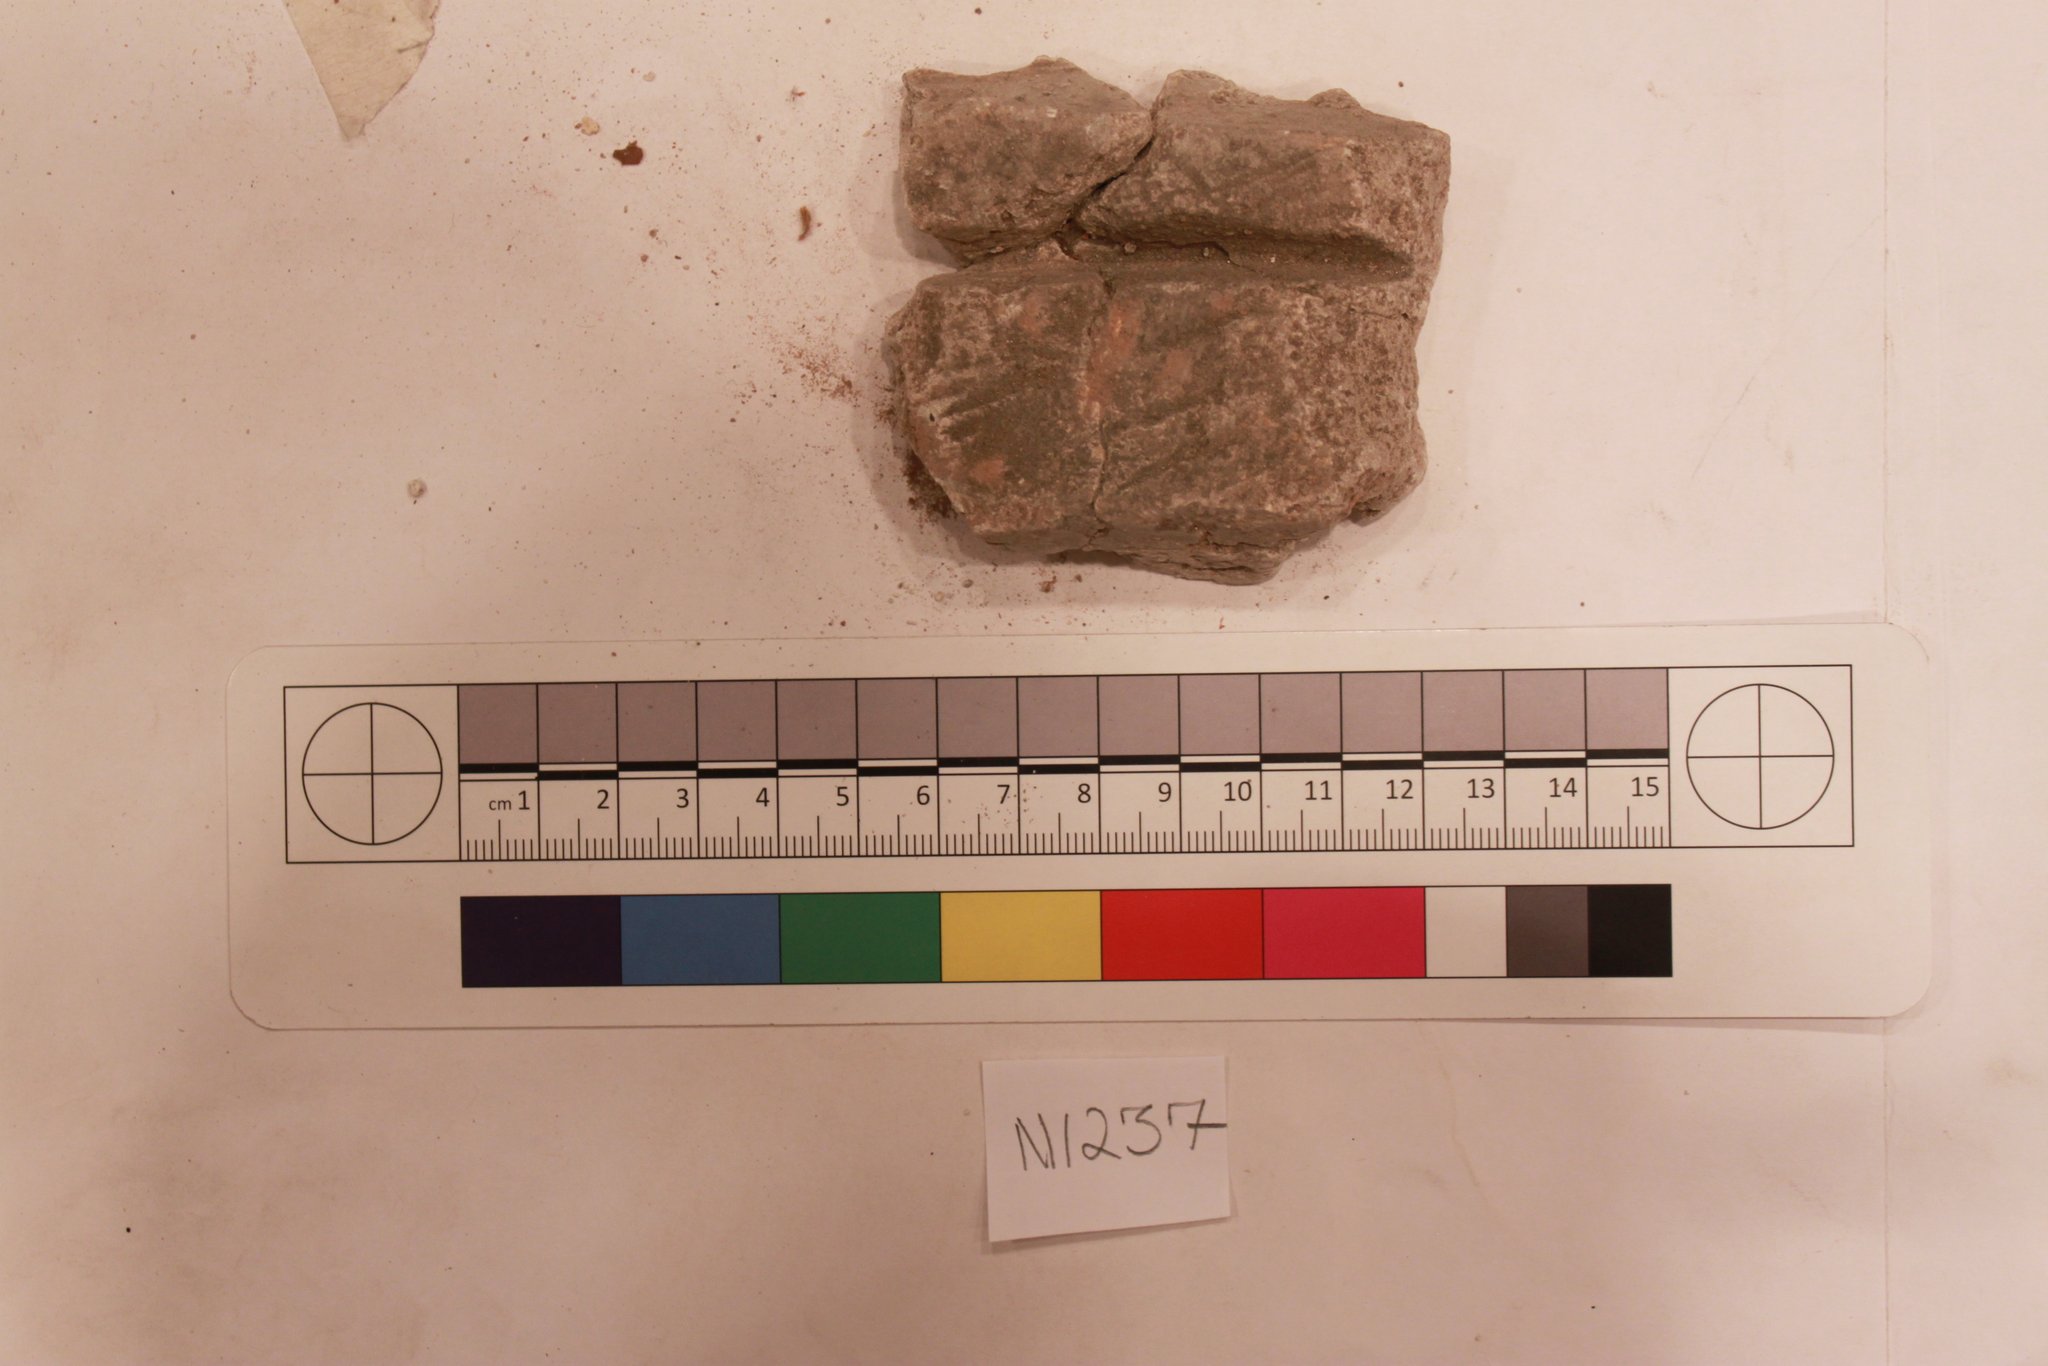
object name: fragment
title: Stucco Fragment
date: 701-1200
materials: plaster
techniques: carving, painting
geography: iran